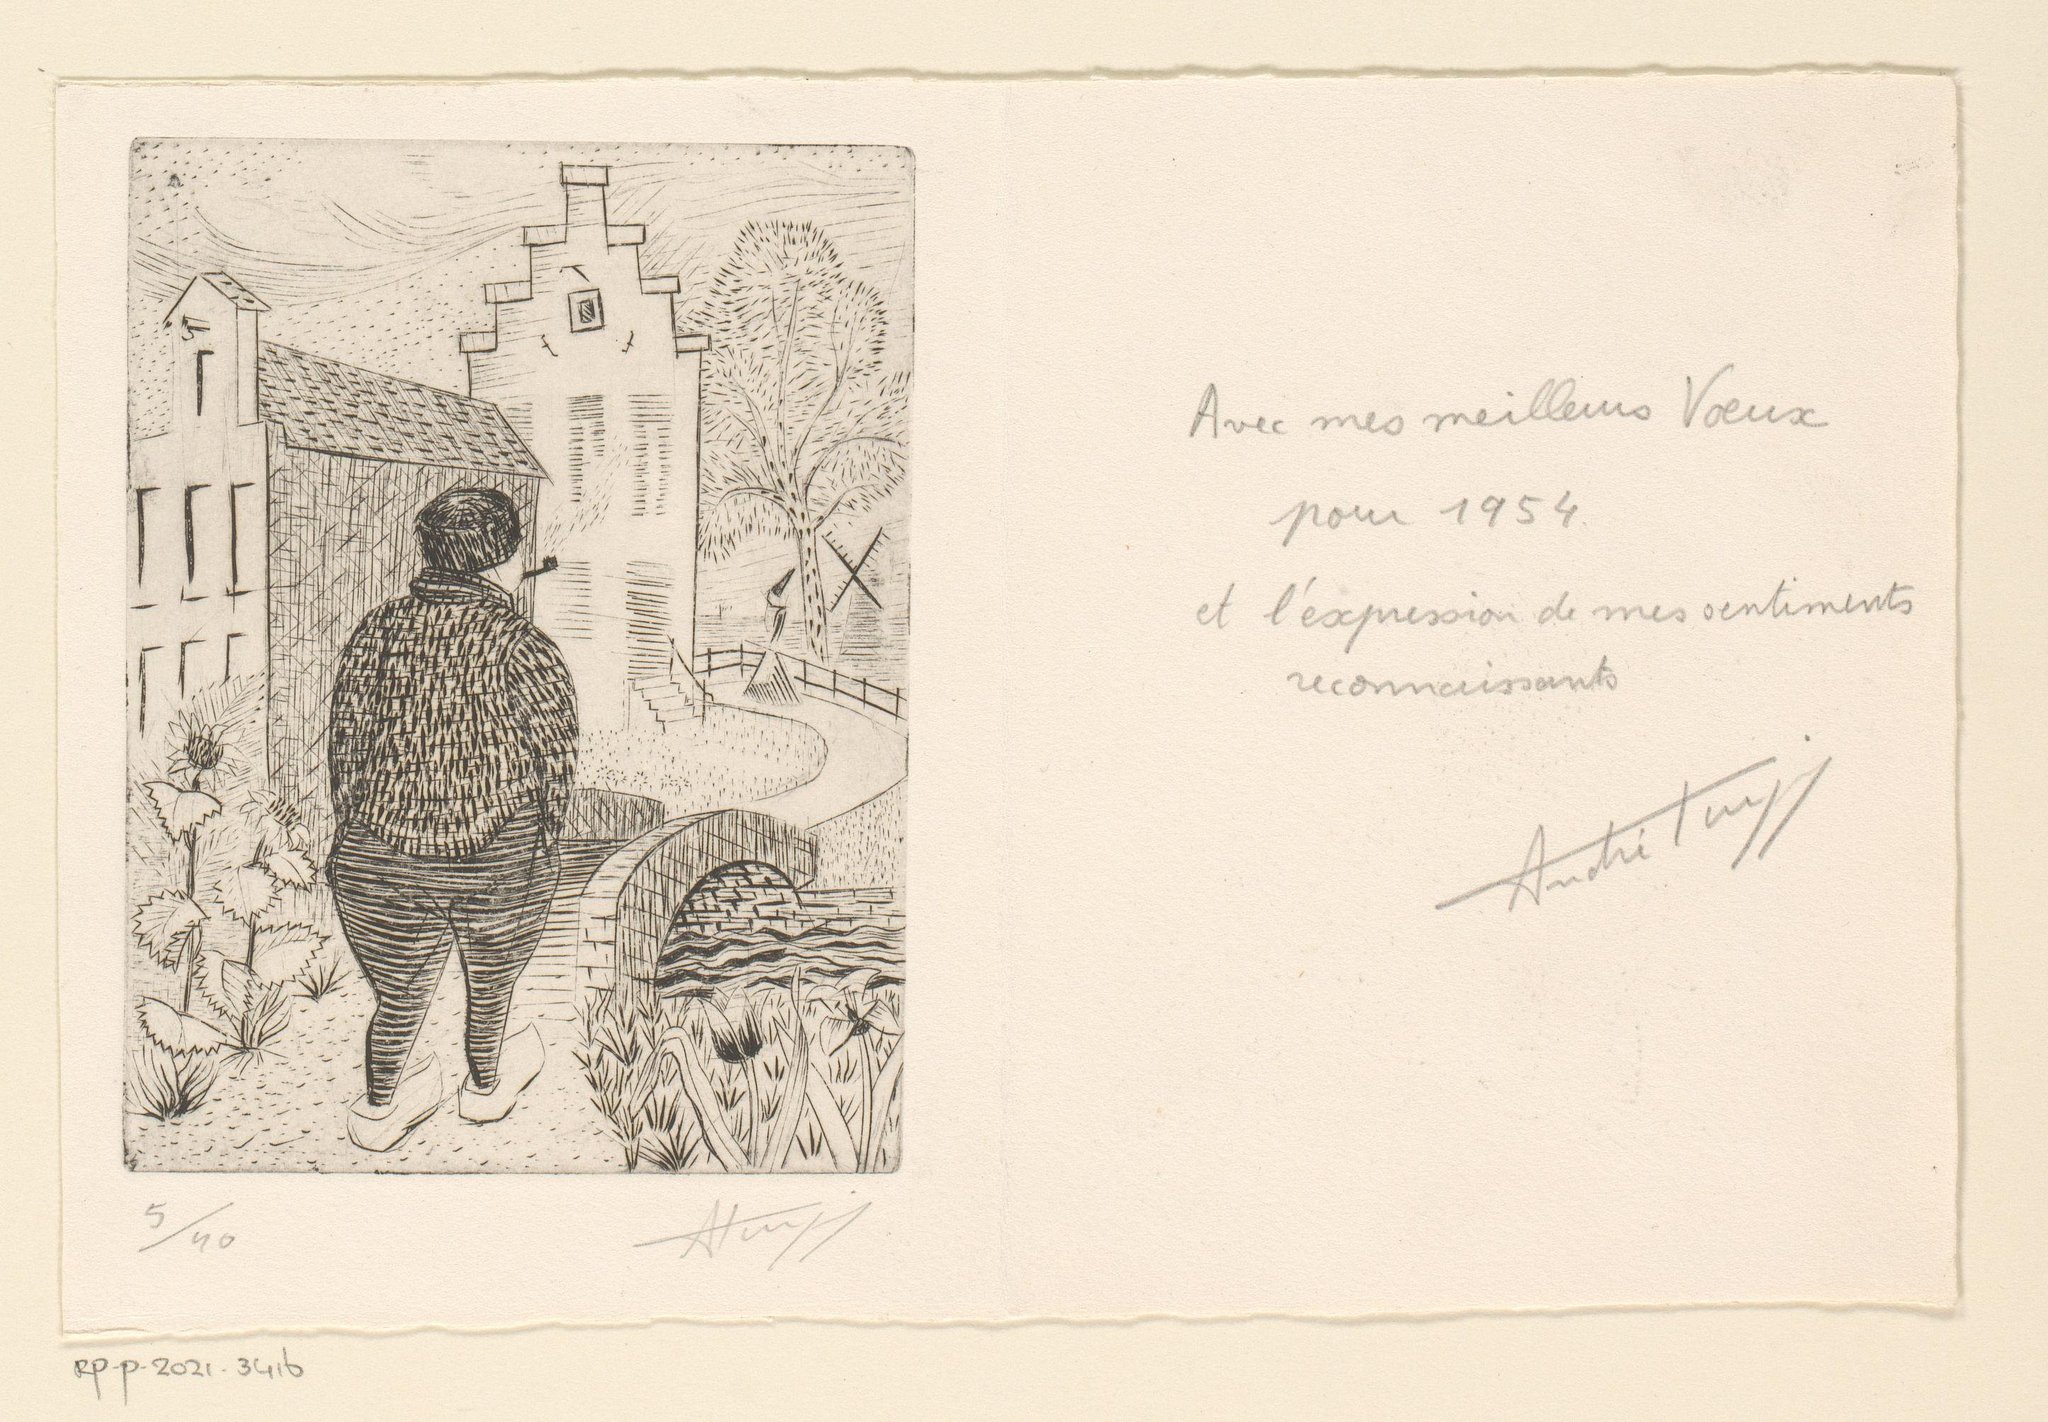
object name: print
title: Nieuwjaarswens voor 1954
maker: Anonymous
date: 1953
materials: paper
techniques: drypoint, etching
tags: wooden shoes, clogs, adult man, bridge, windmill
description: Figuur op klompen tussen bloemen kijkt naar gebouwen in de achtergrond. Rechts daarvan de tekst: 'Avec mes meilleurs Voeux pour 1954 et l'expression de mes sentiments reconnaissants'.